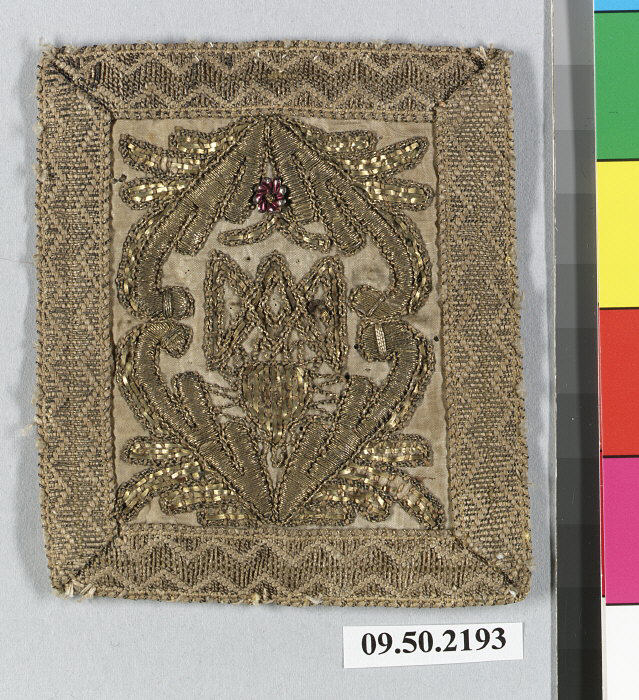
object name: scapular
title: Scapular (?) (one of a pair)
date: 1701-1800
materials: metal thread, silk